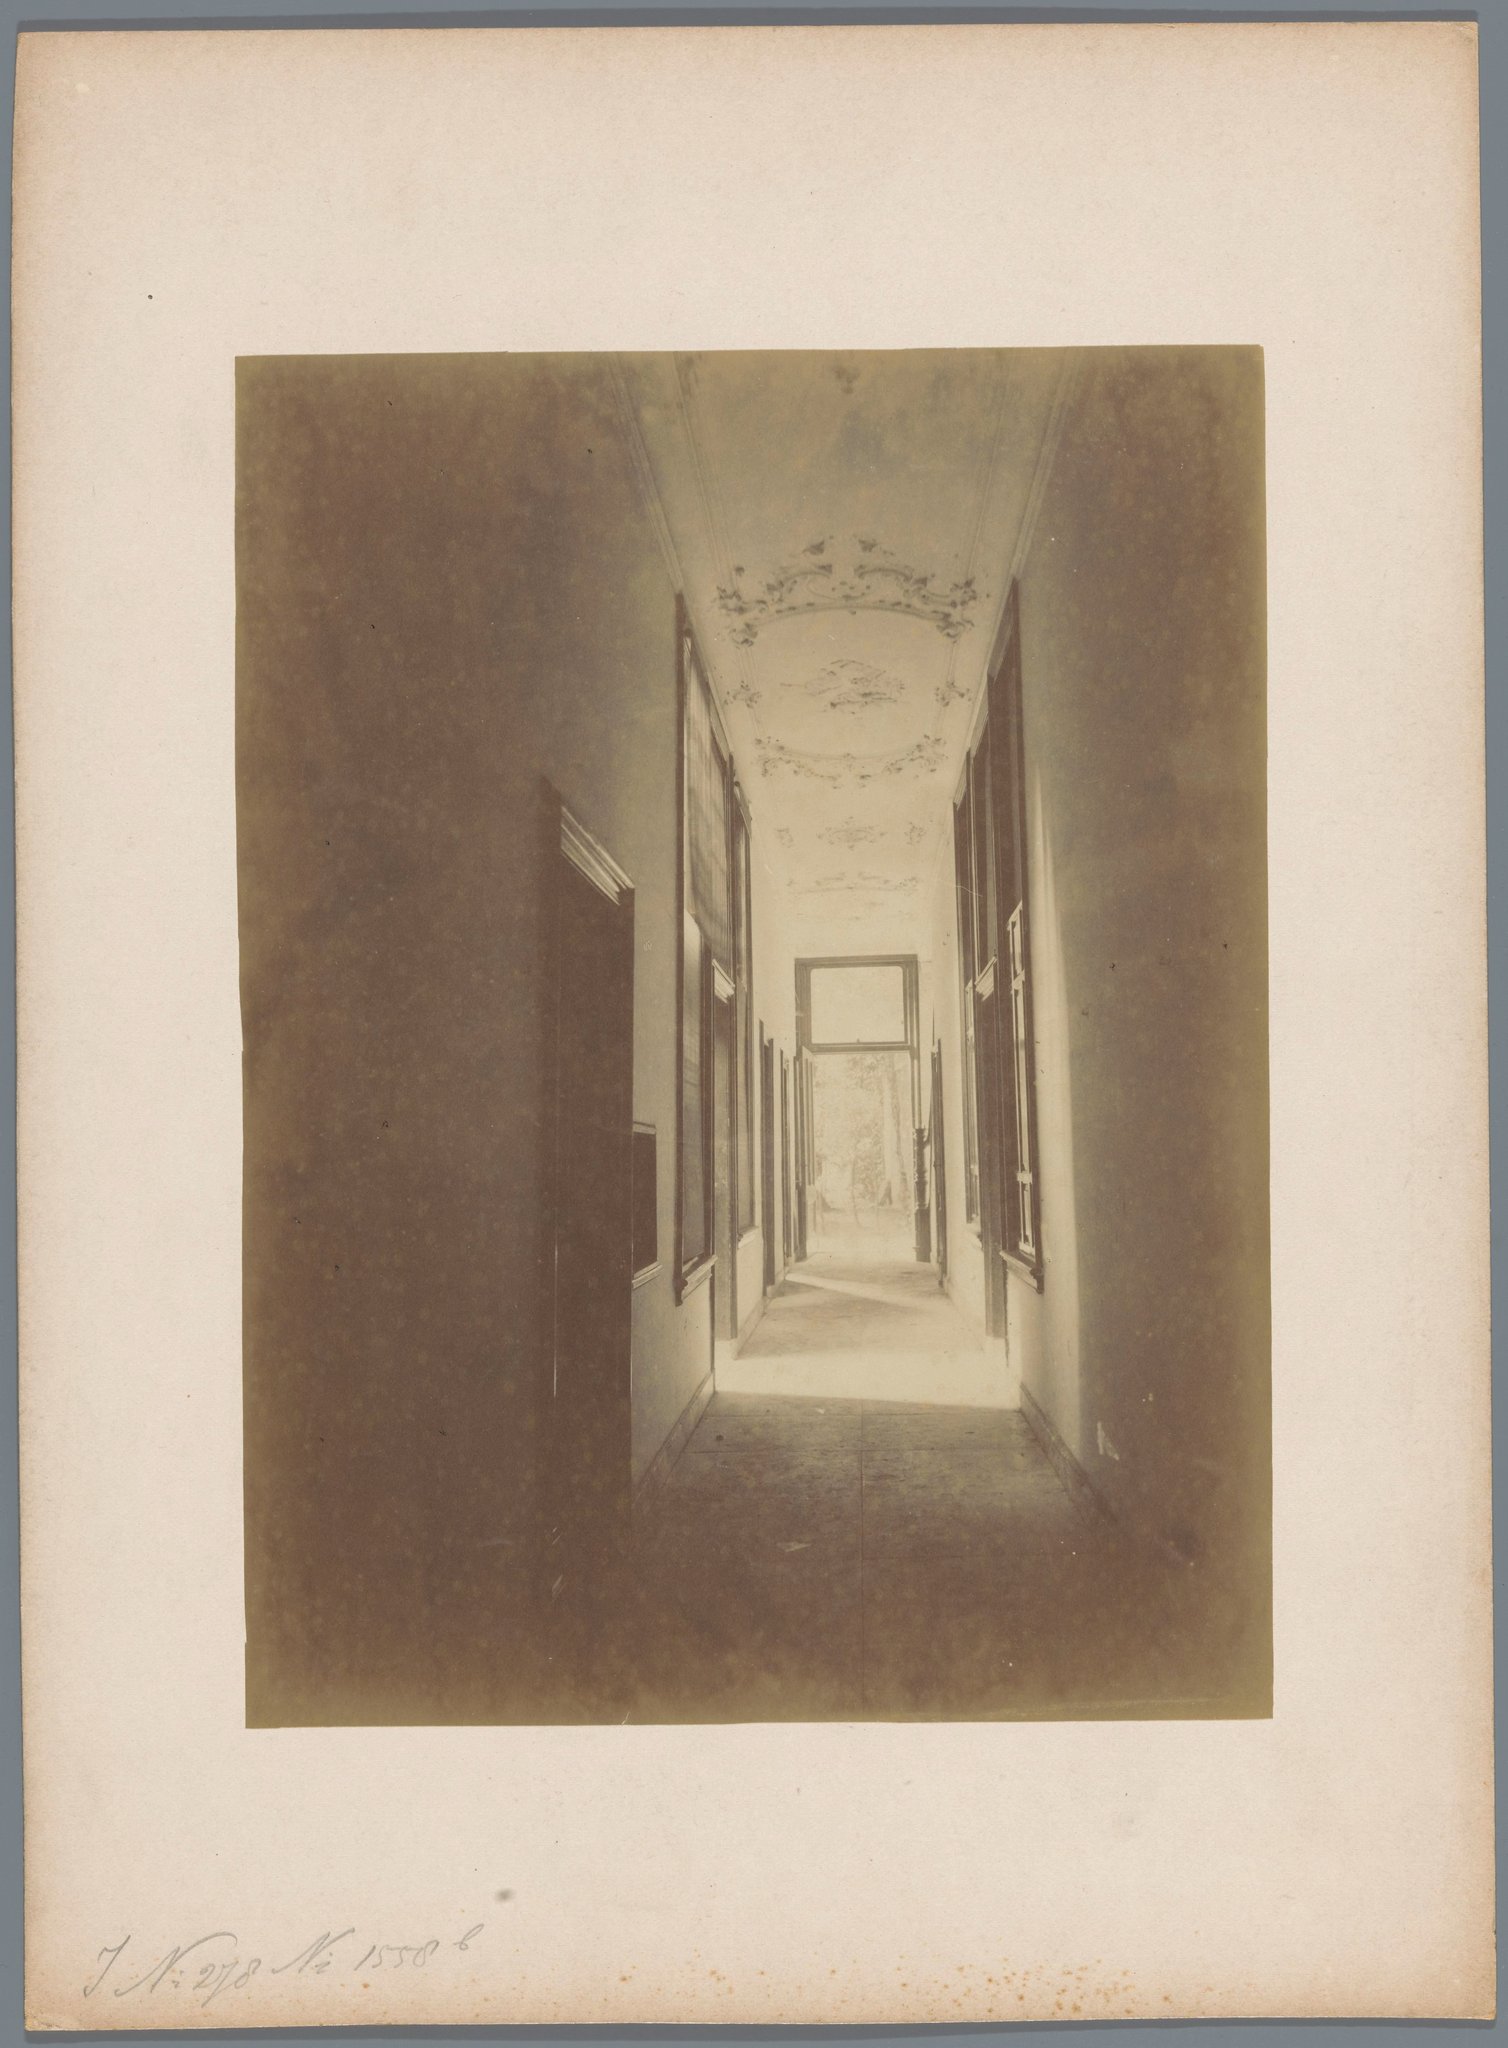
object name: photograph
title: Hal in Huize Wijtenburg aan de Steenschuur te Leiden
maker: Anonymous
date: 1904-1908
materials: cardboard, photographic support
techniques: albumen print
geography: steenschuur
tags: corridor, open door, interior of the house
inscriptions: annotation, inscription: ‘Leiden. Z-H. Steenschuur. Maison Wijtenburg. Aug. 1904.’, inscription: ‘neg. no 15876 foto no 7986’